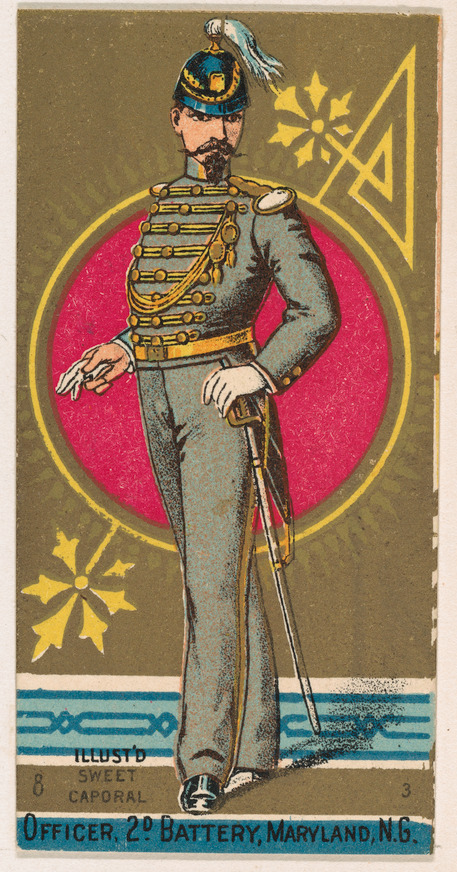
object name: print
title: Officer, 2nd Battery, Maryland, National Guard, from the Military Series (N224) issued by Kinney Tobacco Company to promote Sweet Caporal Cigarettes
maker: kinney brothers tobacco company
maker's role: publisher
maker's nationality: american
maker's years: 1869-2011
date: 1888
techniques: color lithograph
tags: military,soldiers,swords,men